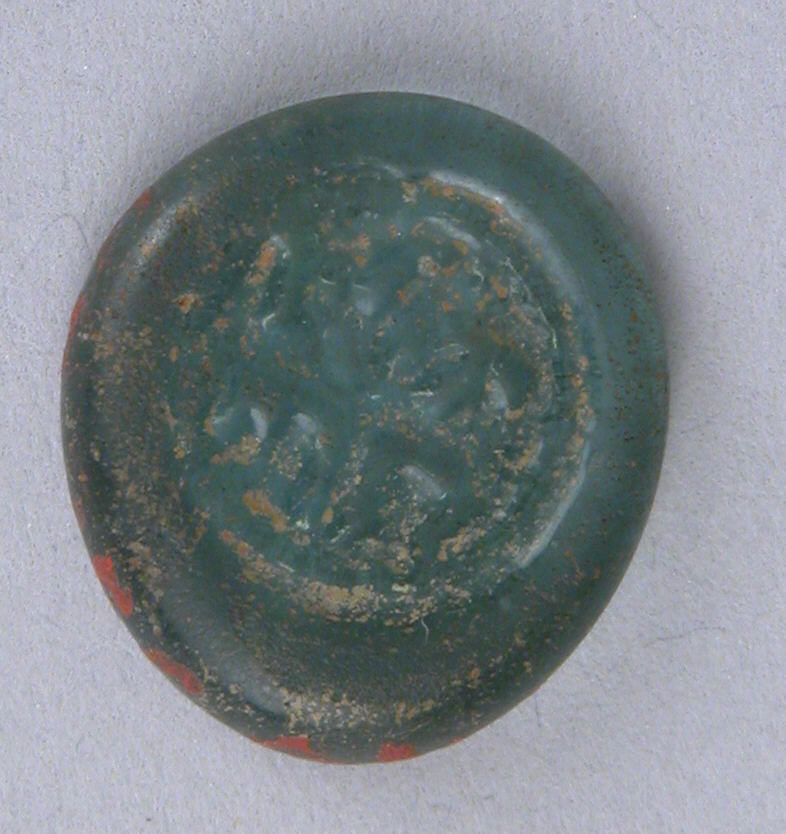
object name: coin weight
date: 901-1100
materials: glass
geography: egypt